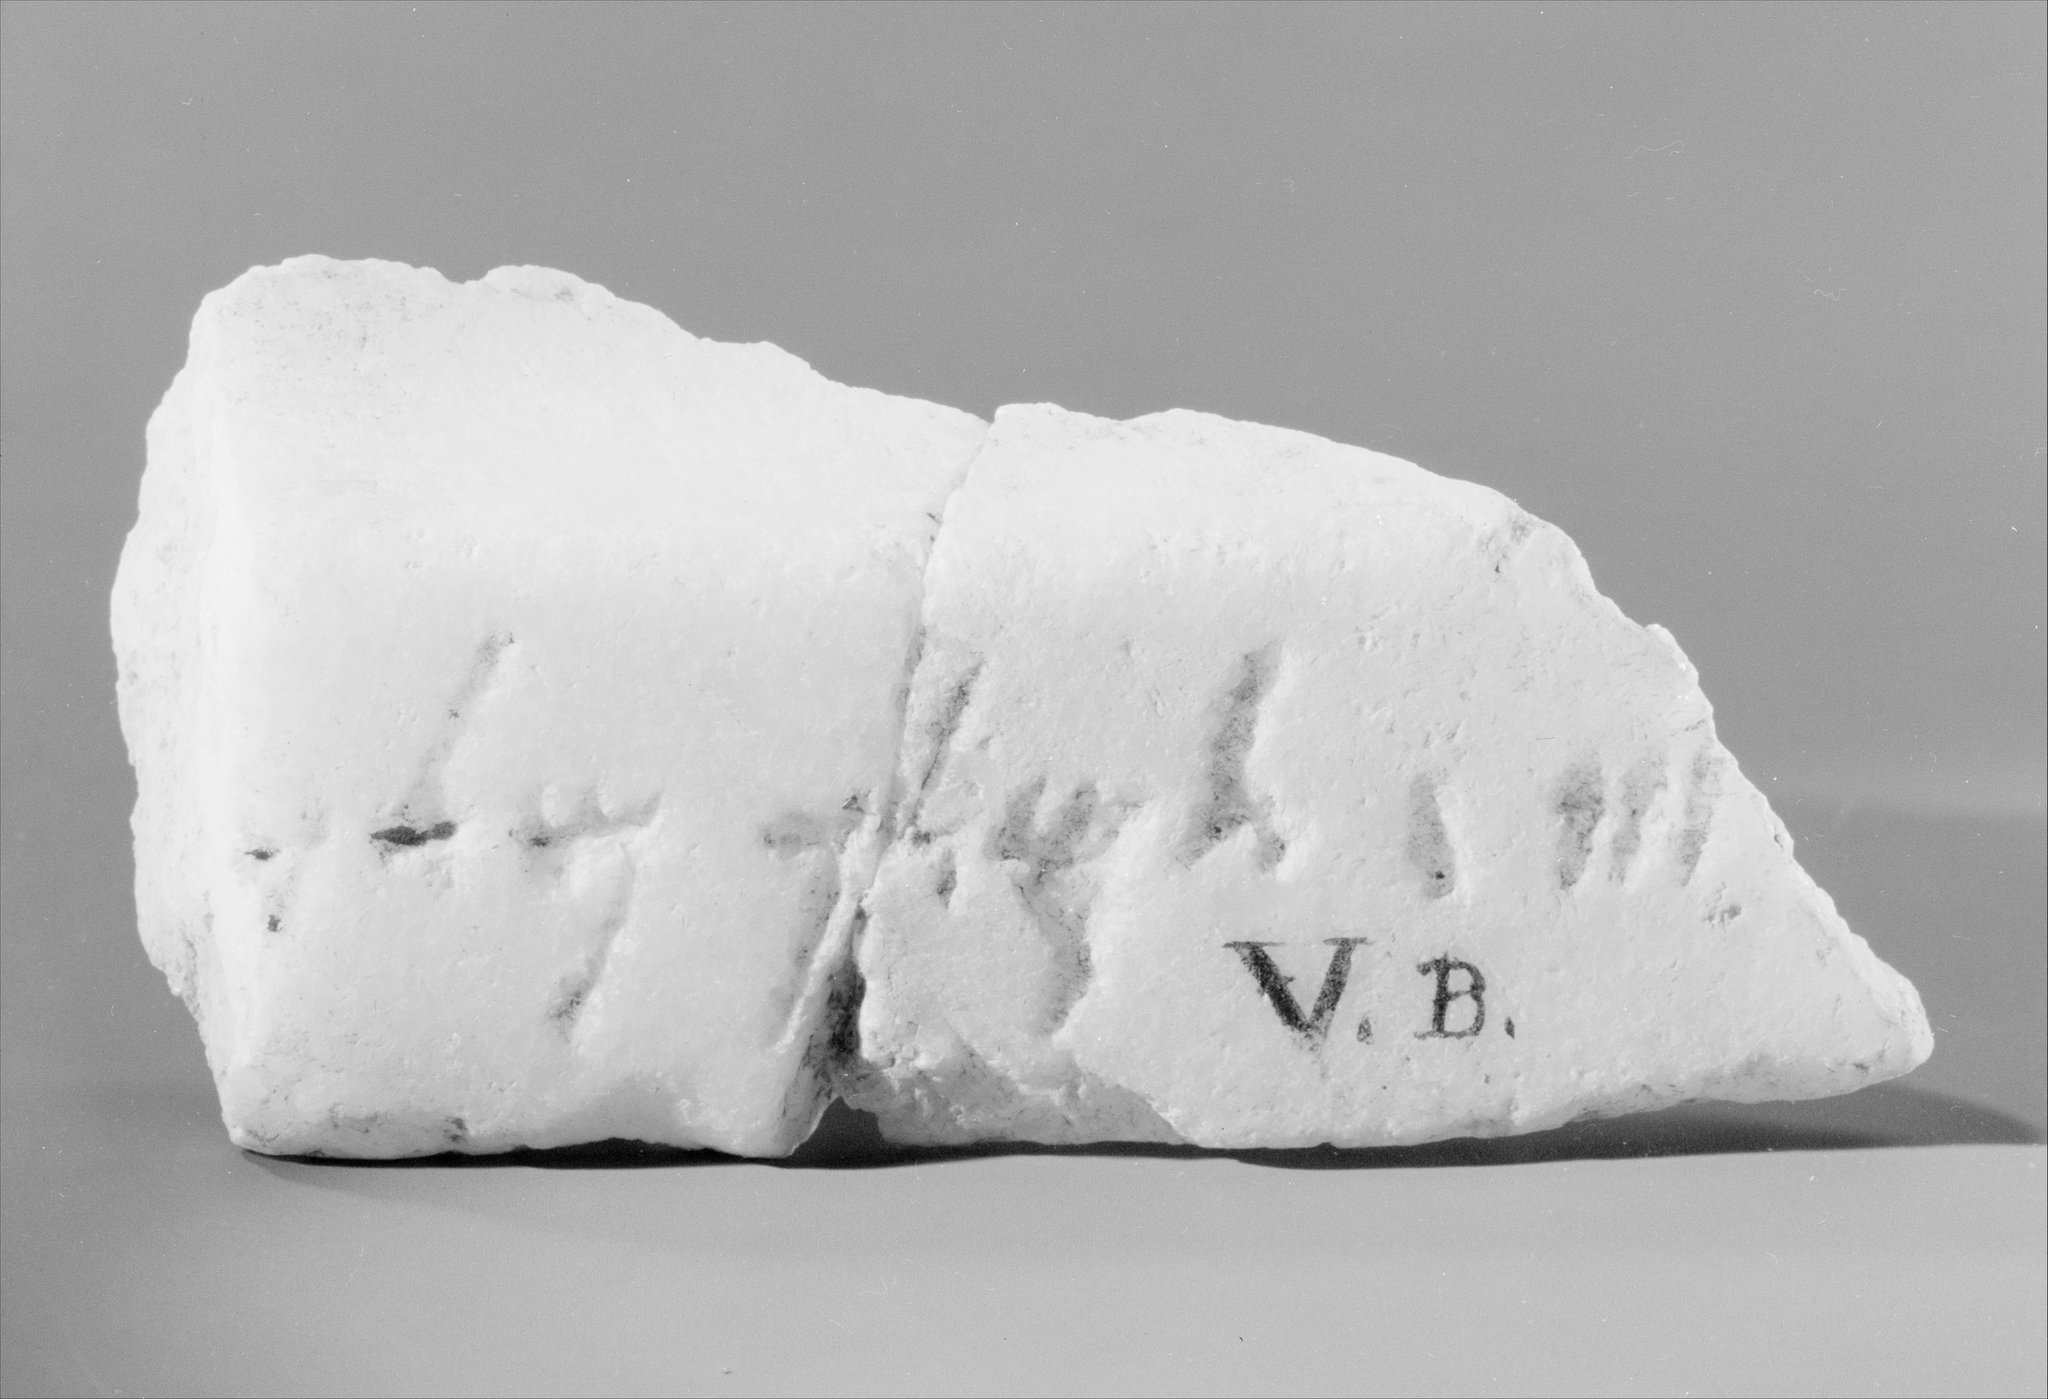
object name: bowl, fragmentary, phoenician inscription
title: Marble bowl fragment with Phoenician inscription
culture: cypriot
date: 389 BCE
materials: marble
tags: phoenician